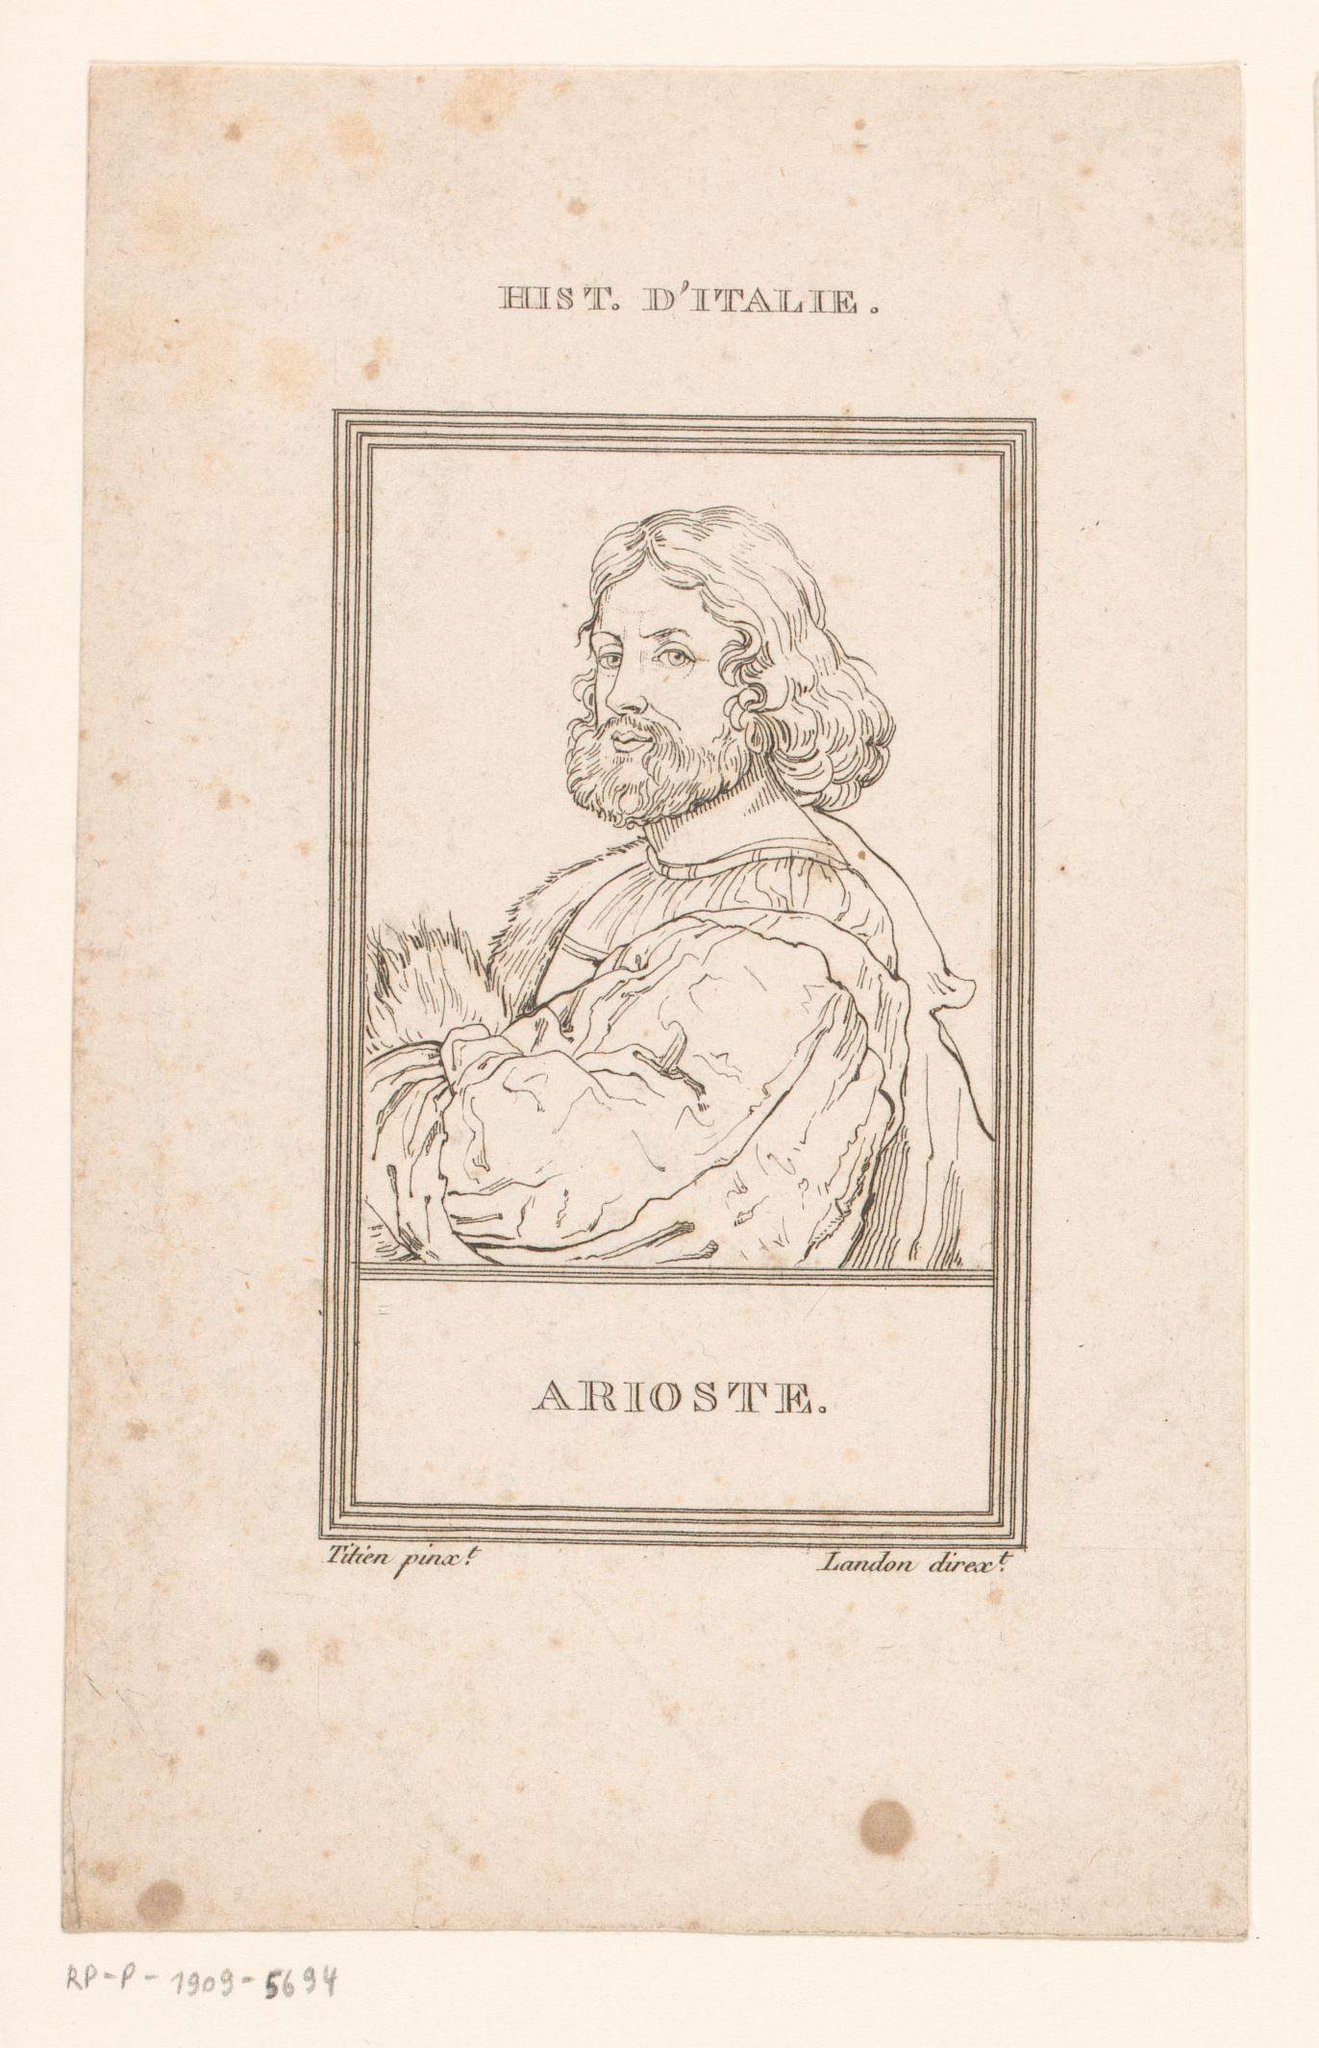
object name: book illustration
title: Portret van Ludovico Ariosto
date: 1805-1811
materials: paper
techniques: etching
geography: france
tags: ludovico ariosto, historical persons, portrait of a writer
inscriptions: collector's mark: Lugt 2228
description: Prent uit: Landon, Charles Paul. Galerie historique des hommes les plus celebres de tous les nations. (...). Parijs: Musée et l'école des beaux-arts, 1805-1811.